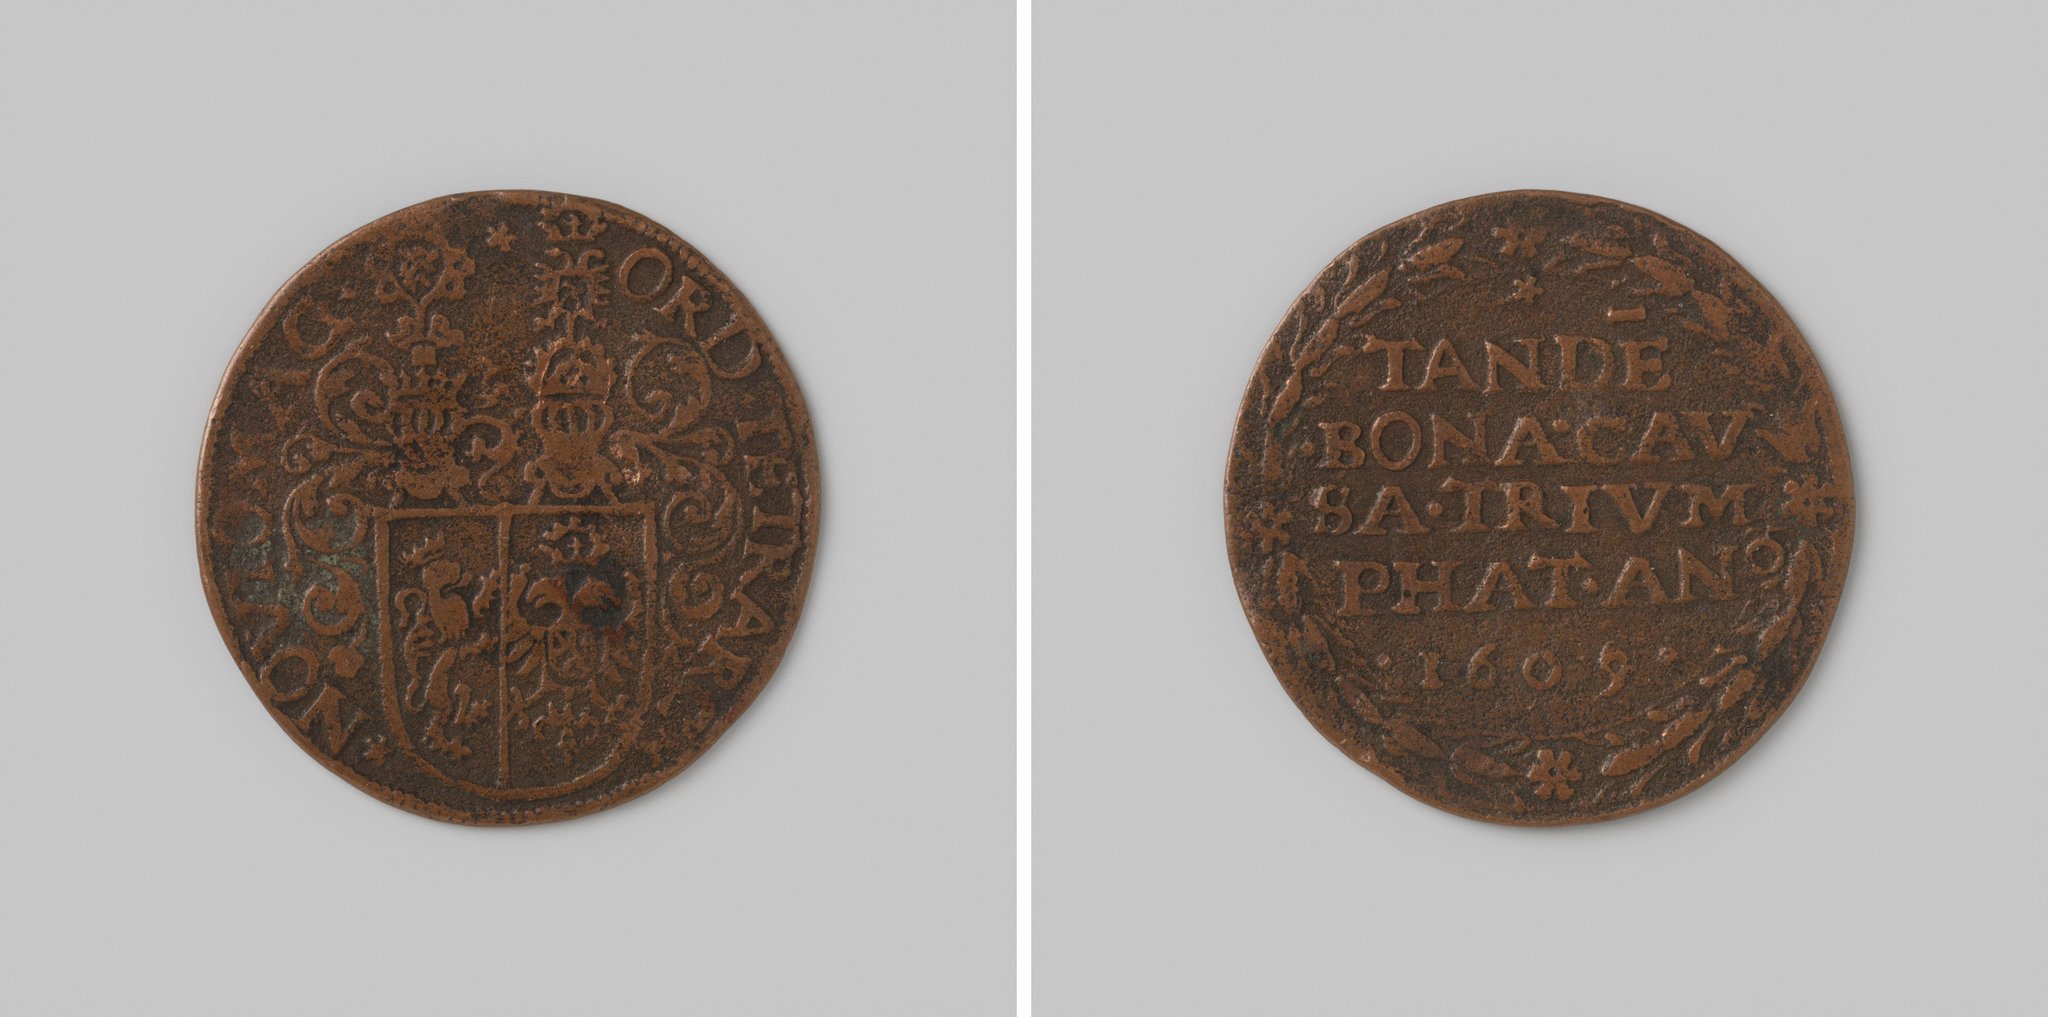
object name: history medal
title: Rekenpenning uit Nijmegen voor de Staten van het Rijk van Nijmegen op het Twaalfjarig Bestand 1609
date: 1609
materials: copper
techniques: striking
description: Koperen penning, op de voorzijde een dubbel gehelmd wapenschild met omschrift, op de keerzijde vijf regels tekst binnen een lauwerkrans.